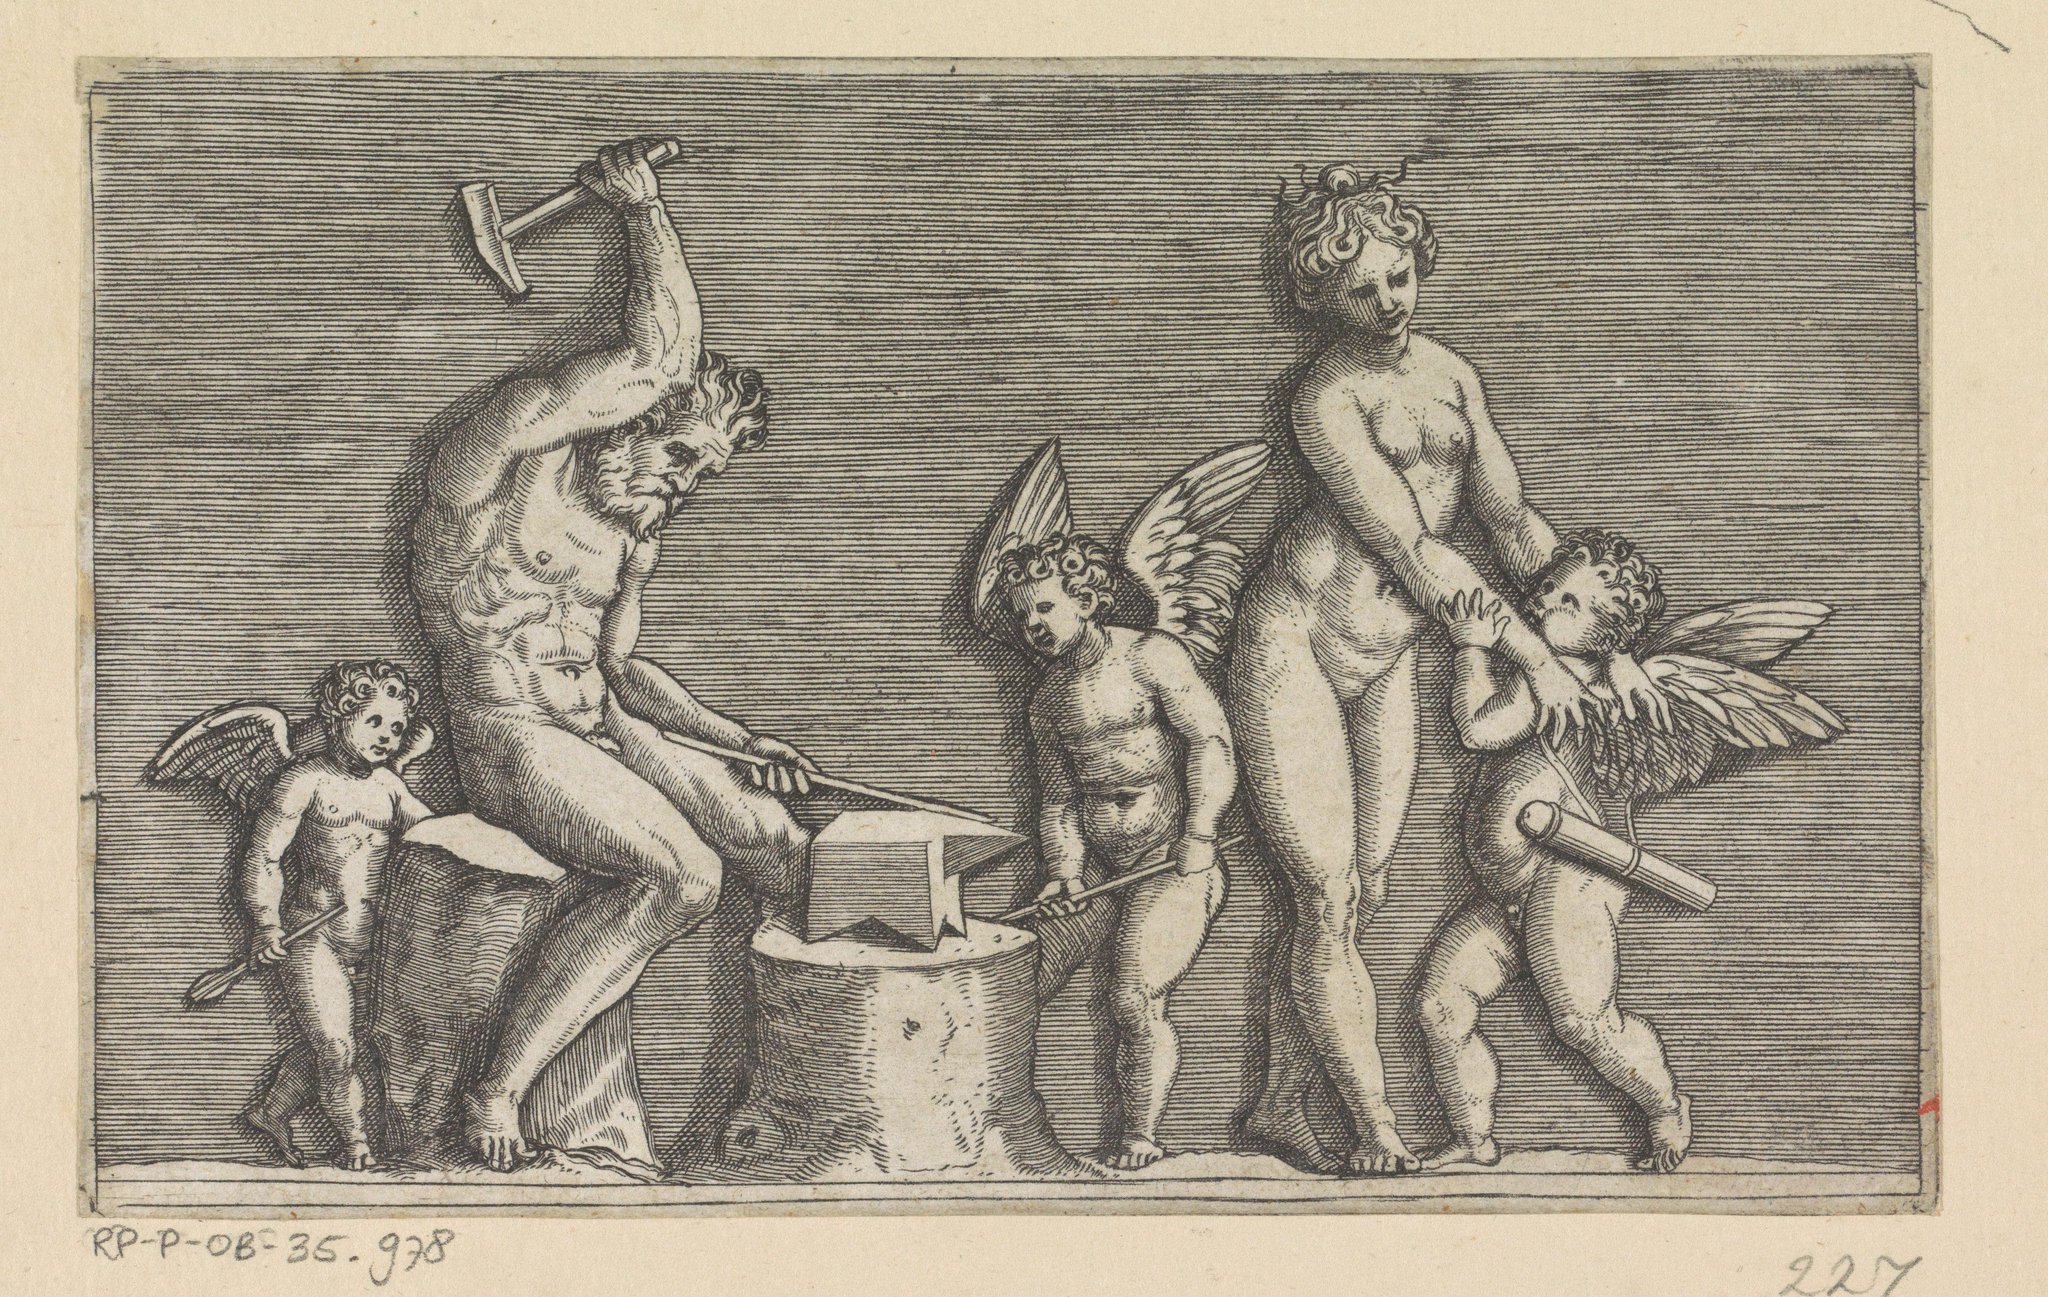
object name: print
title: Antieke reliëfs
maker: marco dente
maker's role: print maker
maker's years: 1486-1527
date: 1498-1532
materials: paper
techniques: engraving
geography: italy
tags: (story of) vulcan (hephaestus), (story of) venus (aphrodite), cupids: 'amores', 'amoretti', 'putti'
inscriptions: collector's mark: Lugt 12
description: Vulcanus slaat met een hamer op een aambeeld. Achter hem staat een putto. Rechts staat Venus met twee putti.